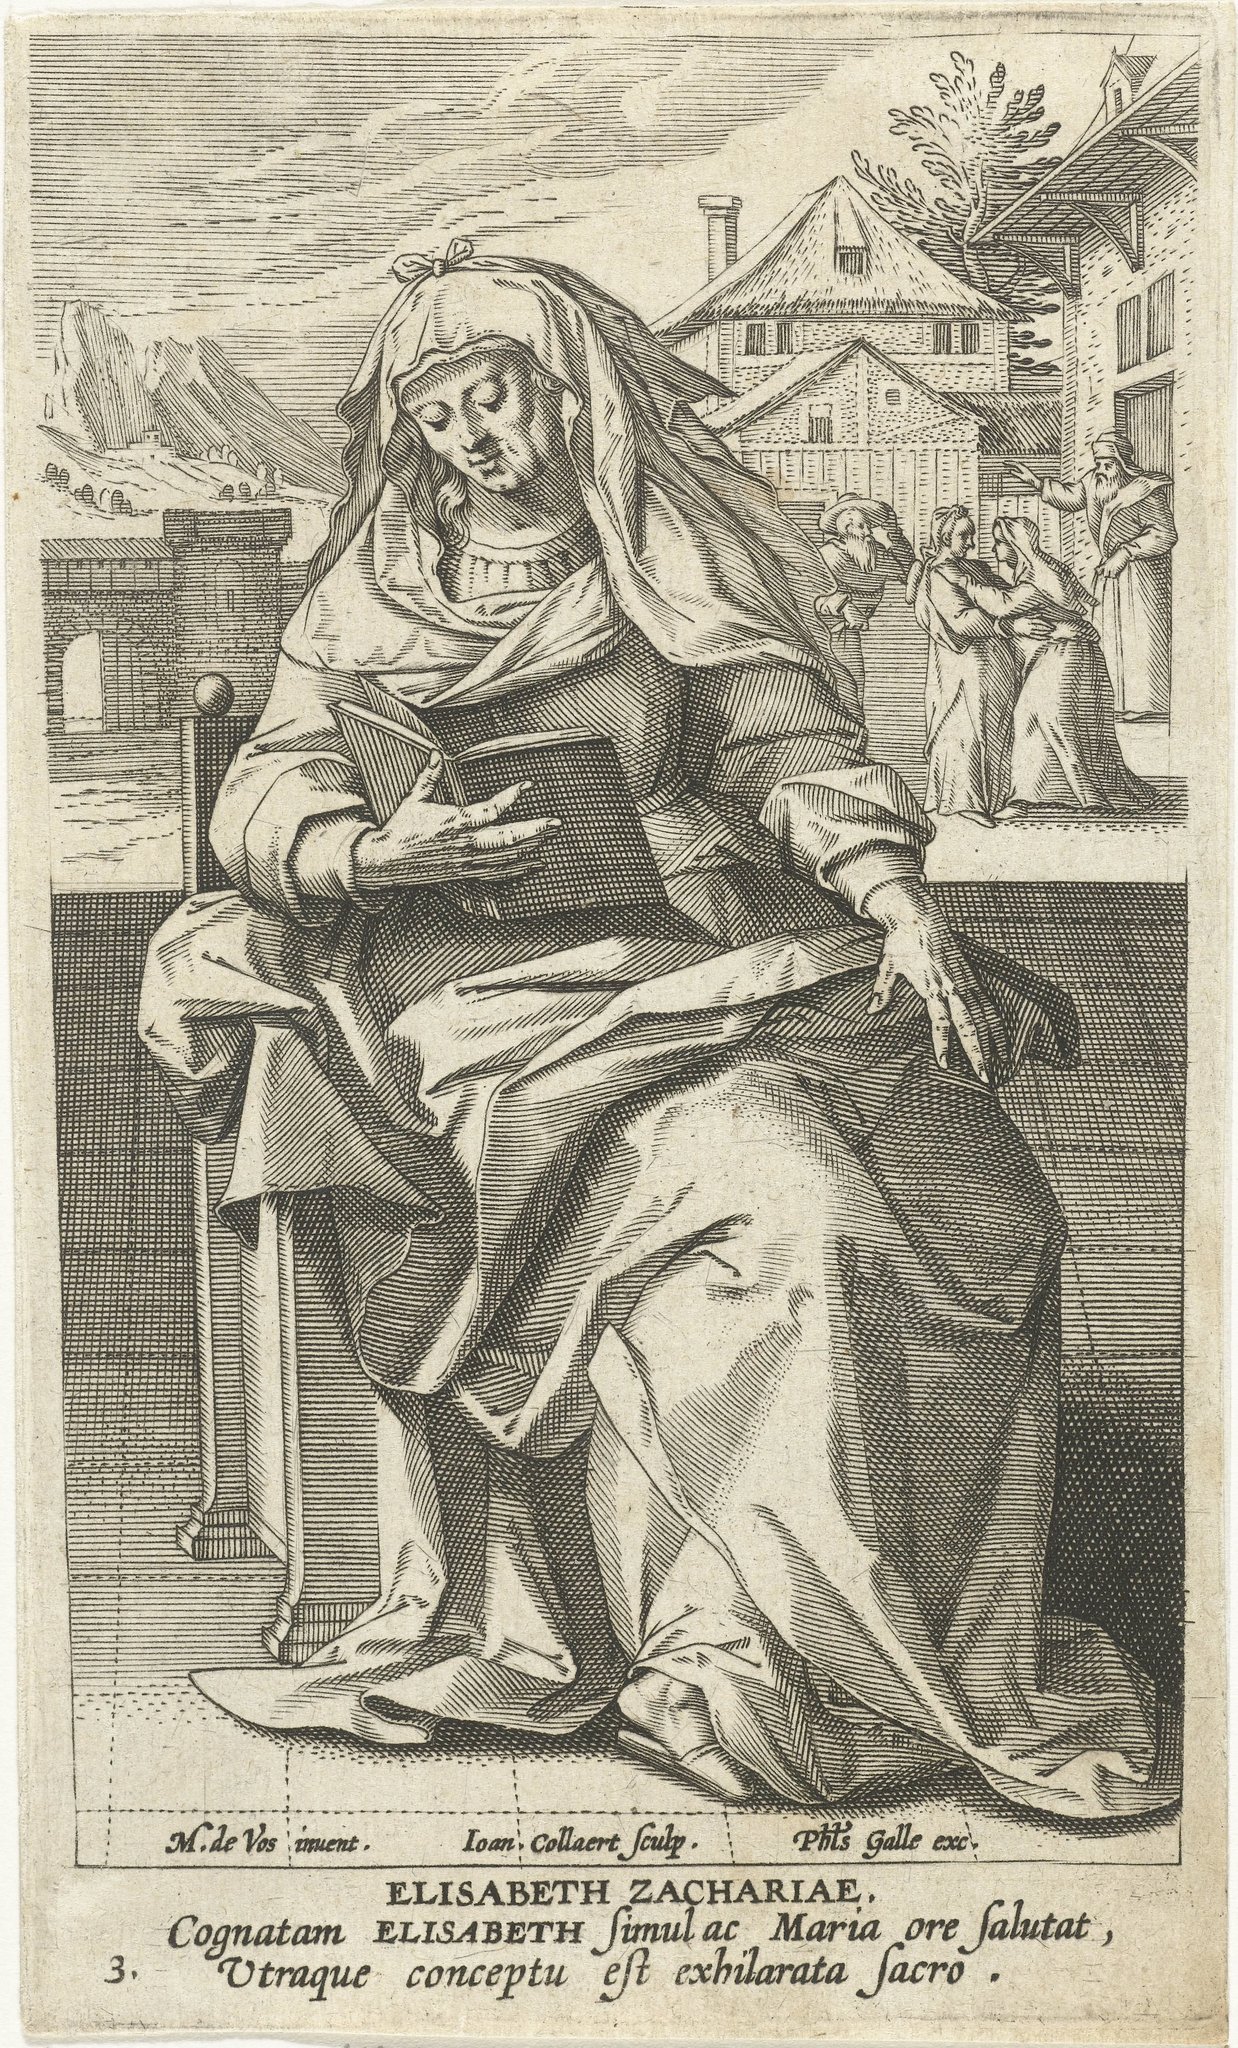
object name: print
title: Elisabeth Zachariae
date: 1595-1599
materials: paper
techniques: engraving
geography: antwerp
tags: mary and elisabeth, both pregnant, embracing, elisabeth, mother of john the baptist; possible attributes: john the baptist as child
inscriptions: collector's mark: Lugt 2228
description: Op de voorgrond de Elisabet, moeder van Johannes de Doper, lezend op een stoel. Op de achtergrond de ontmoeting tussen Elisabet en Maria. De prent heeft een Latijns onderschrift en maakt deel uit van een prentserie met beroemde vrouwen uit het Nieuwe Testament.